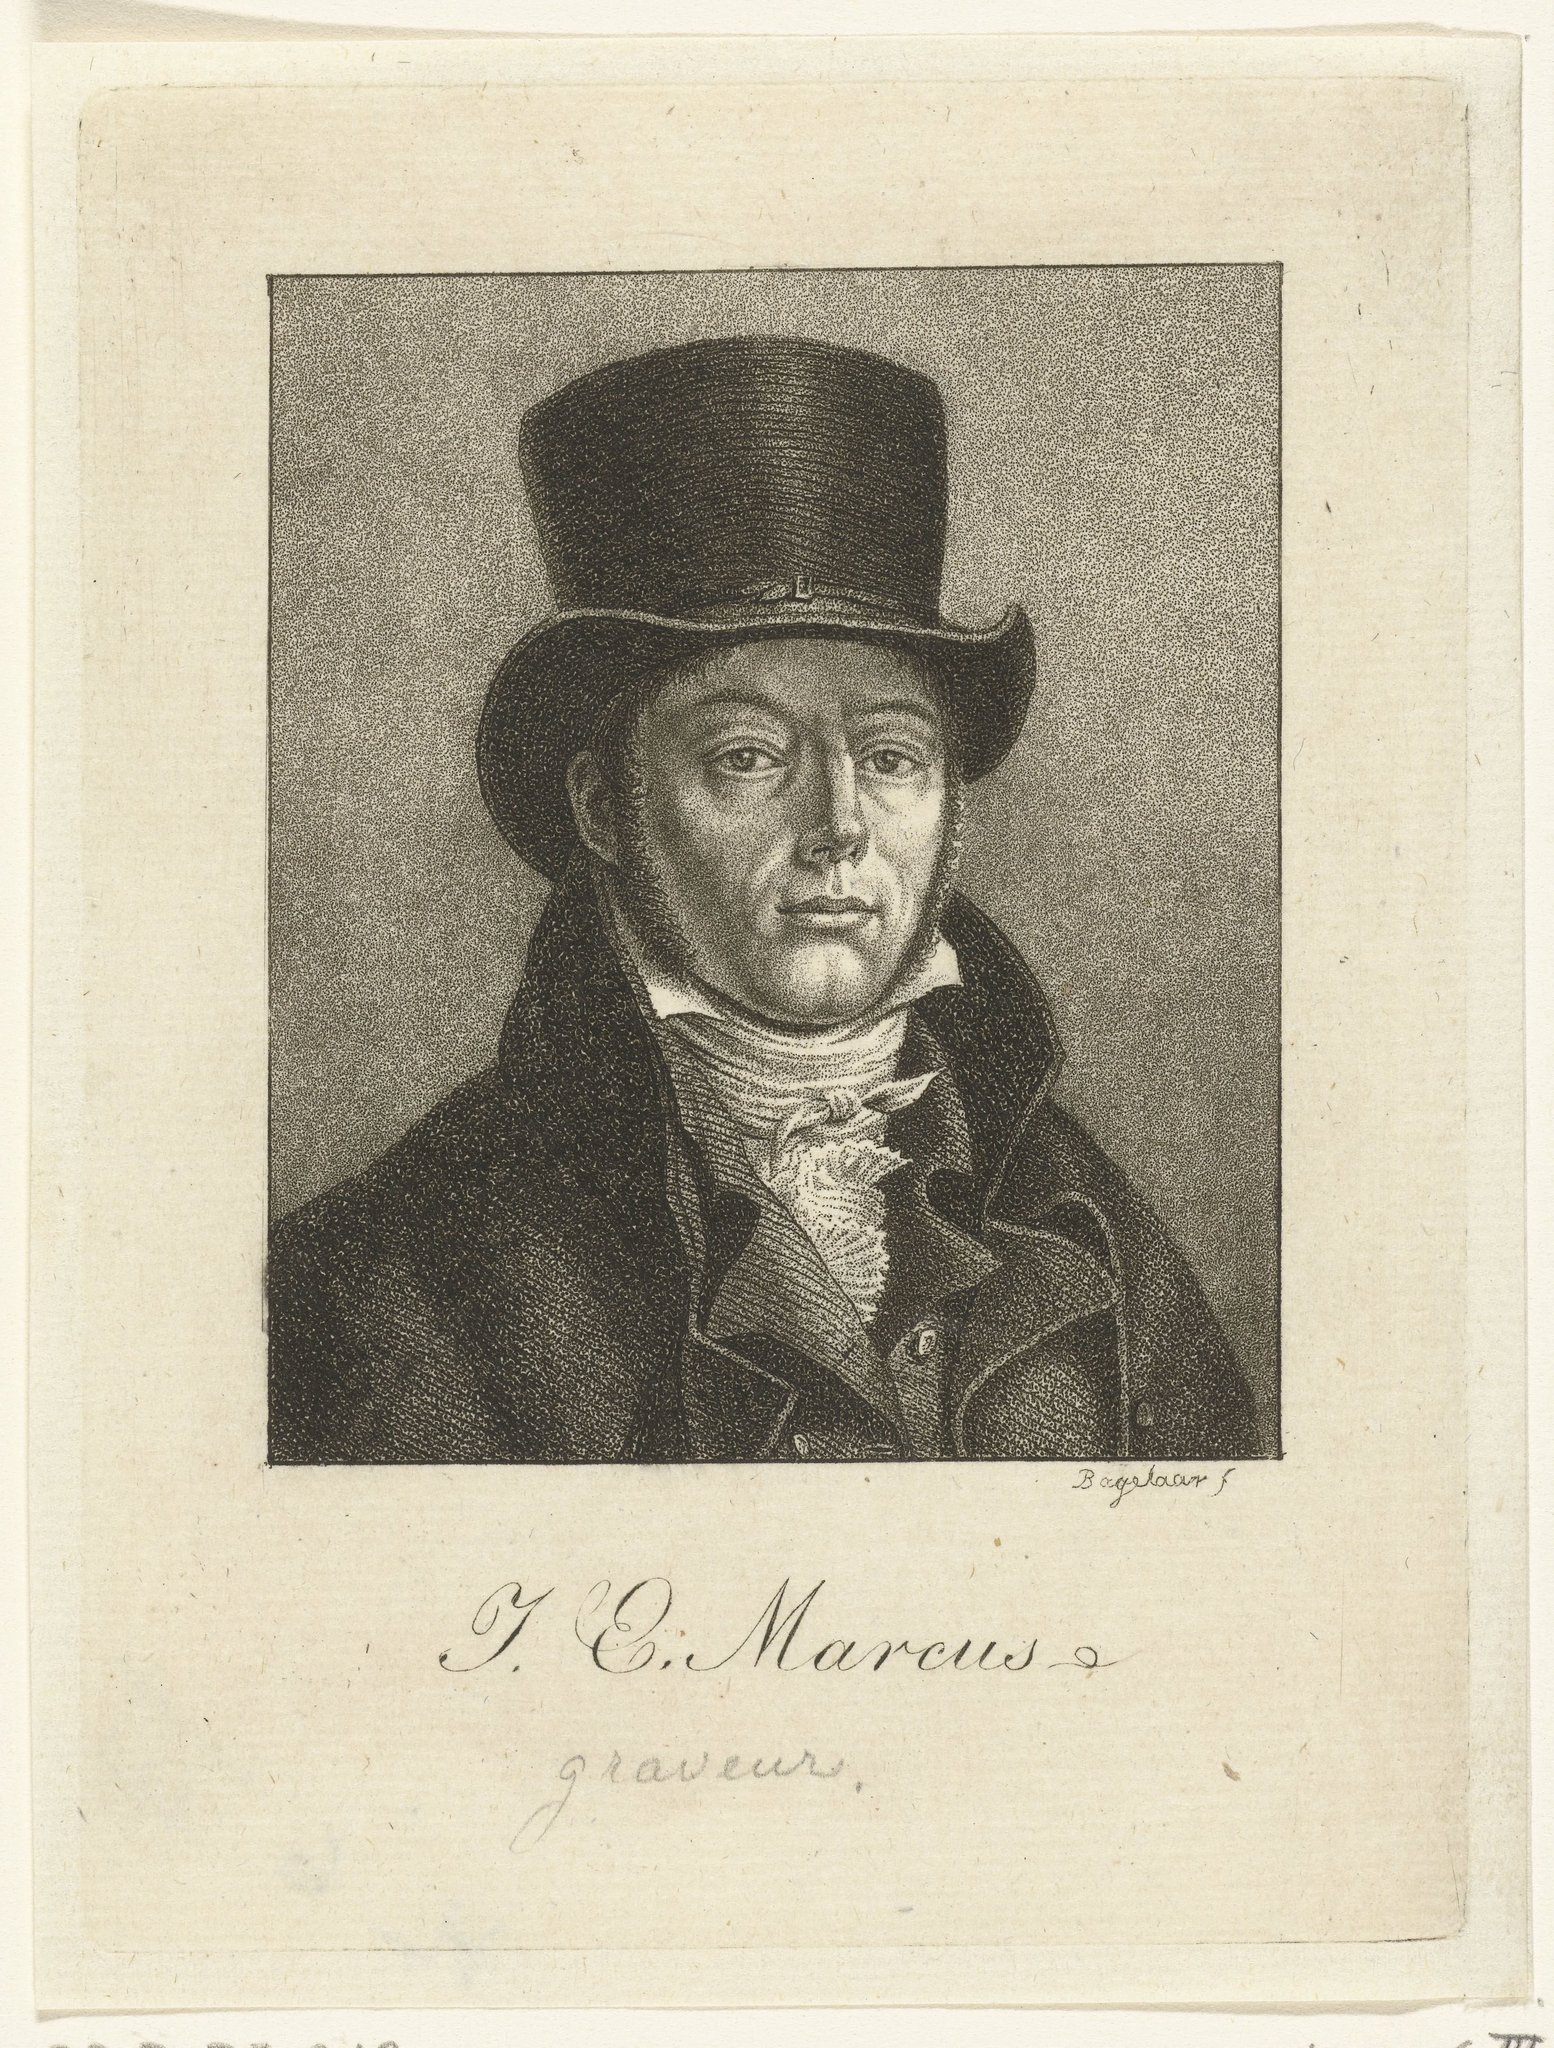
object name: print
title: Portret van Jacob Ernst Marcus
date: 1798-1826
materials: paper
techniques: aquatint, etching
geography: netherlands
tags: print maker, draughtsman, jacob ernst marcus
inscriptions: collector's mark: Lugt 2228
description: Portretbuste van Jacob Ernst Marcus met hoed en mantel.